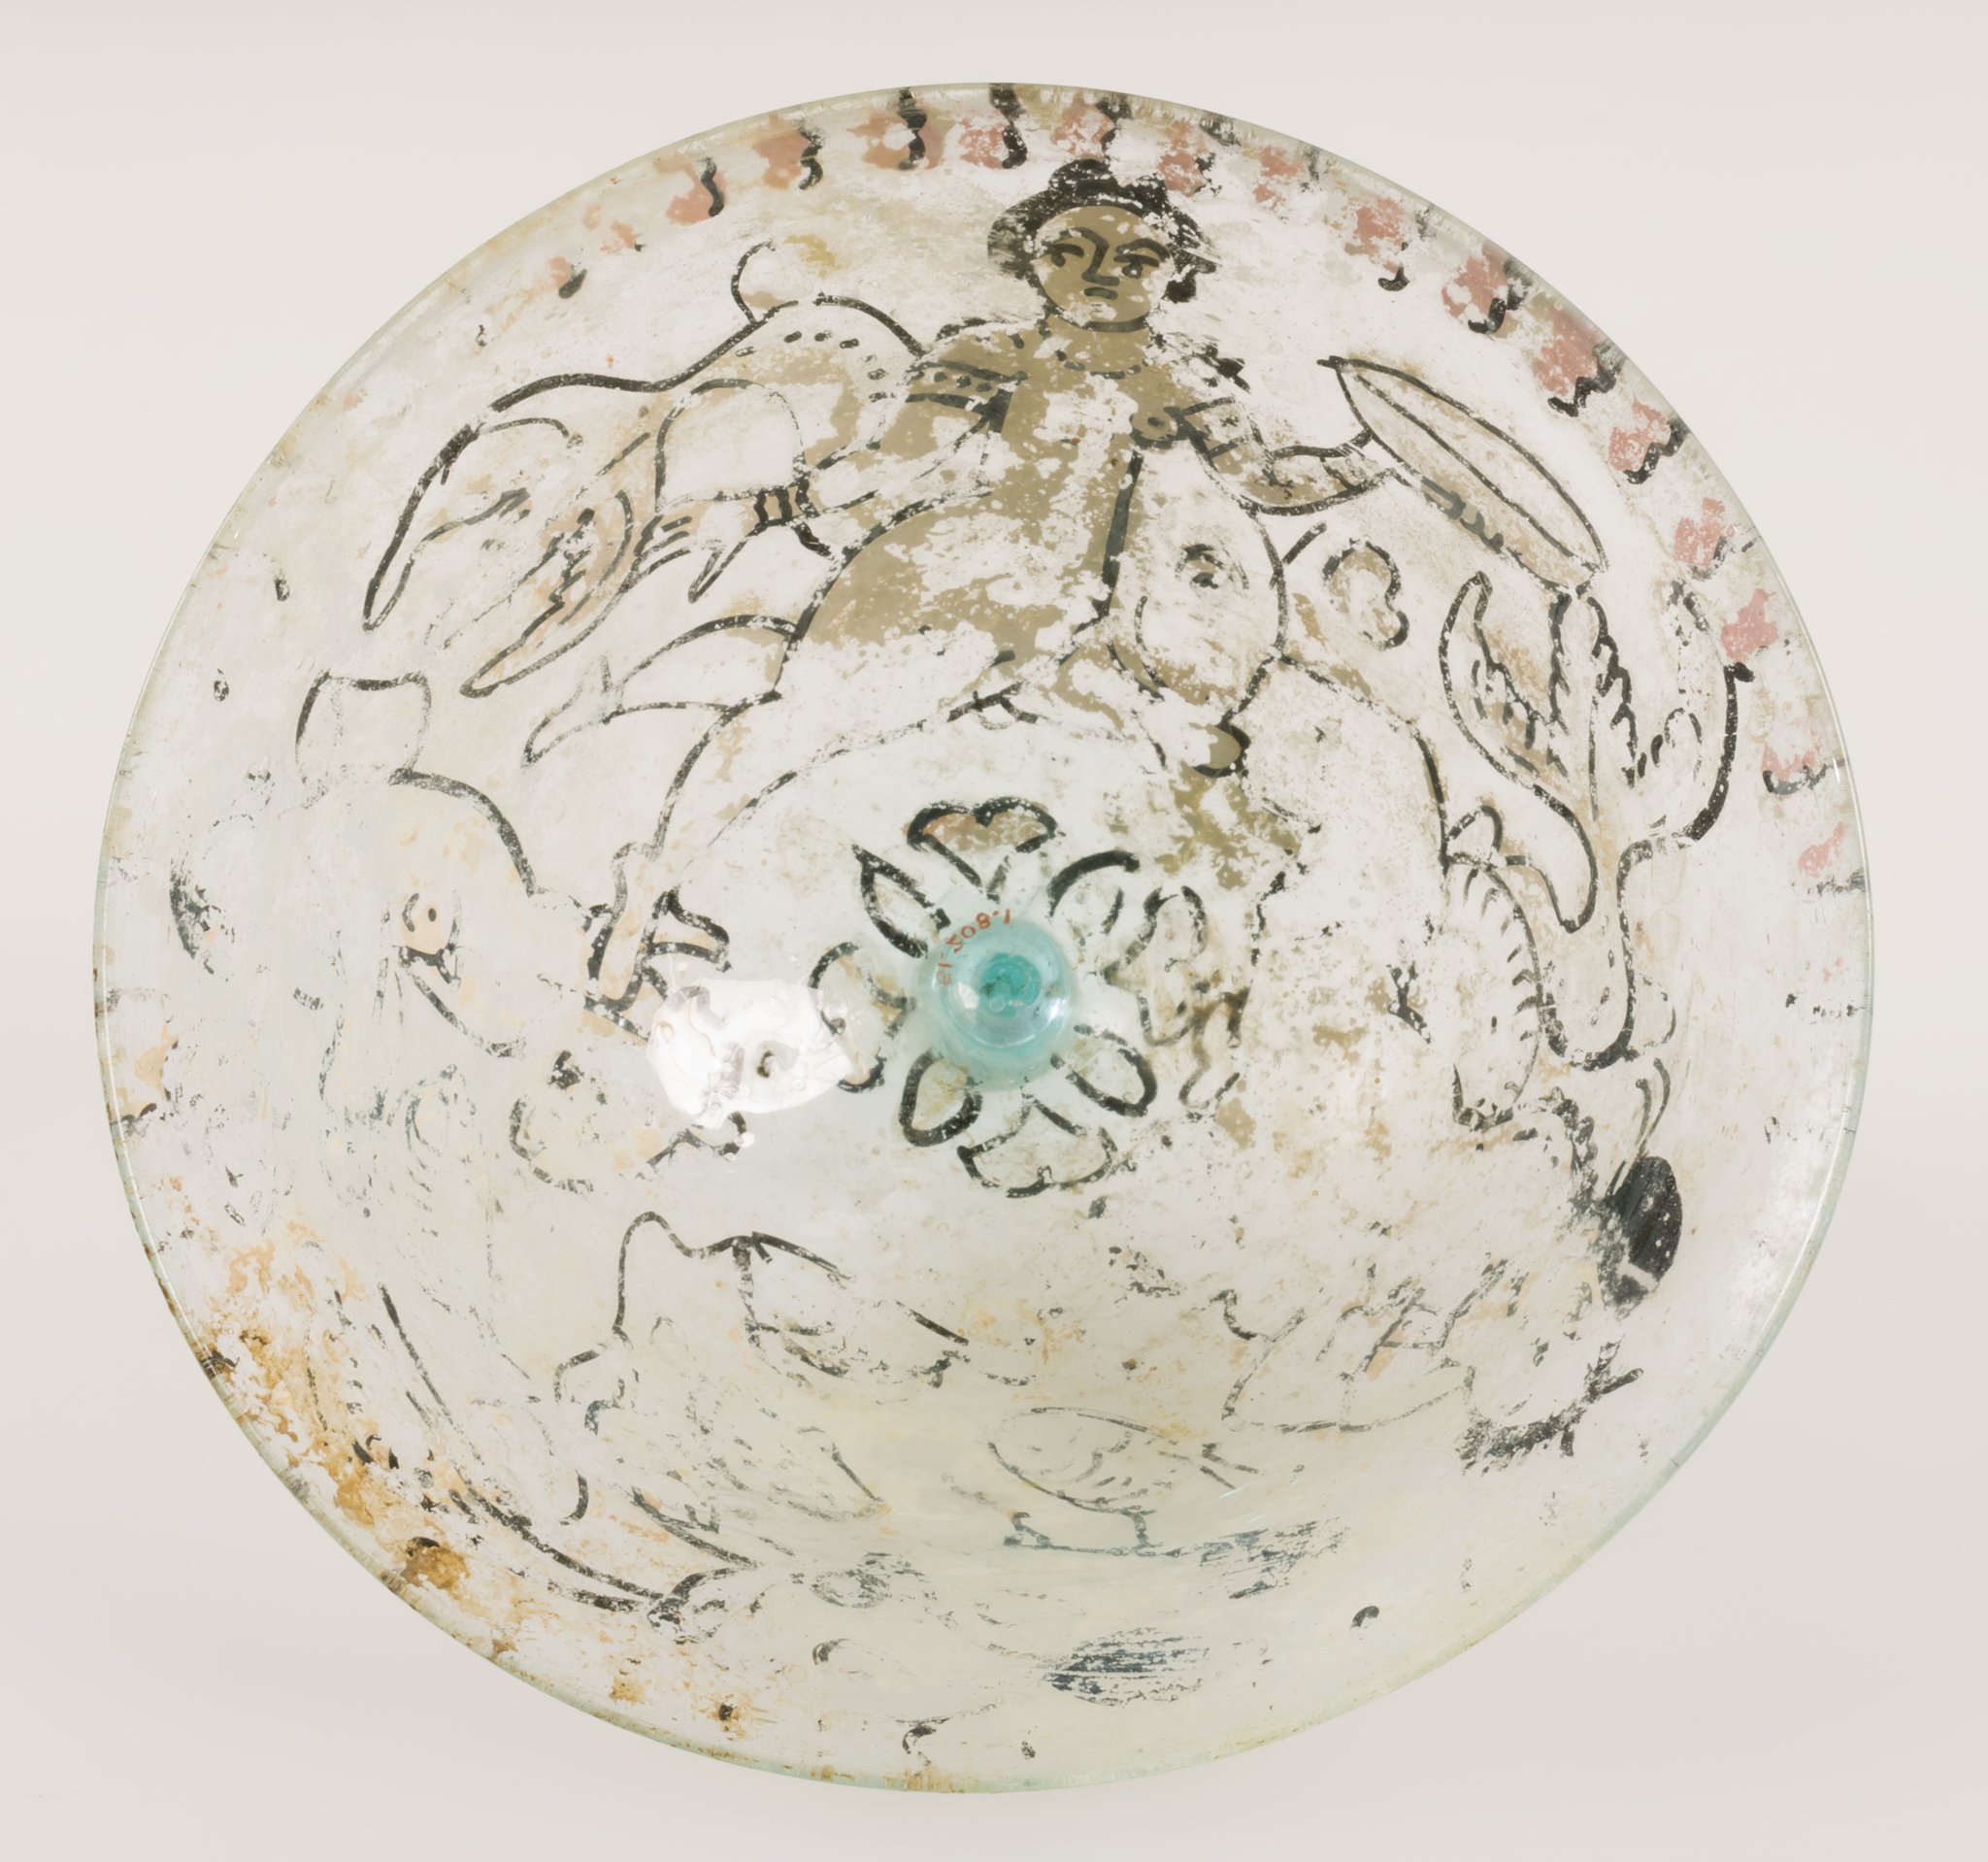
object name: goblet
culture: coptic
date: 301-400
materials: glass, paint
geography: egypt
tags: female nudes,dolphins